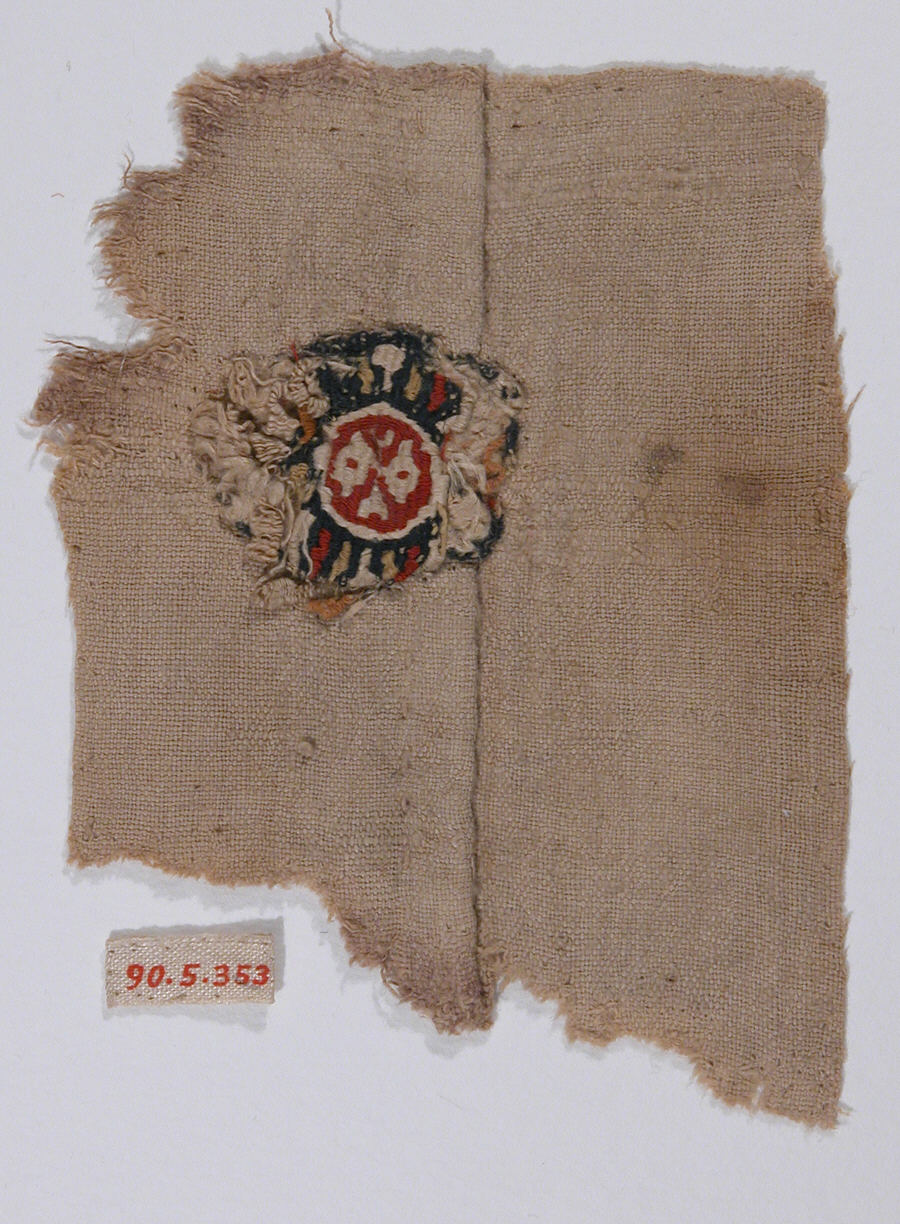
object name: textile fragment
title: Fragment of a Tunic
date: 401-600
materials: linen, wool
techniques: weave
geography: egypt